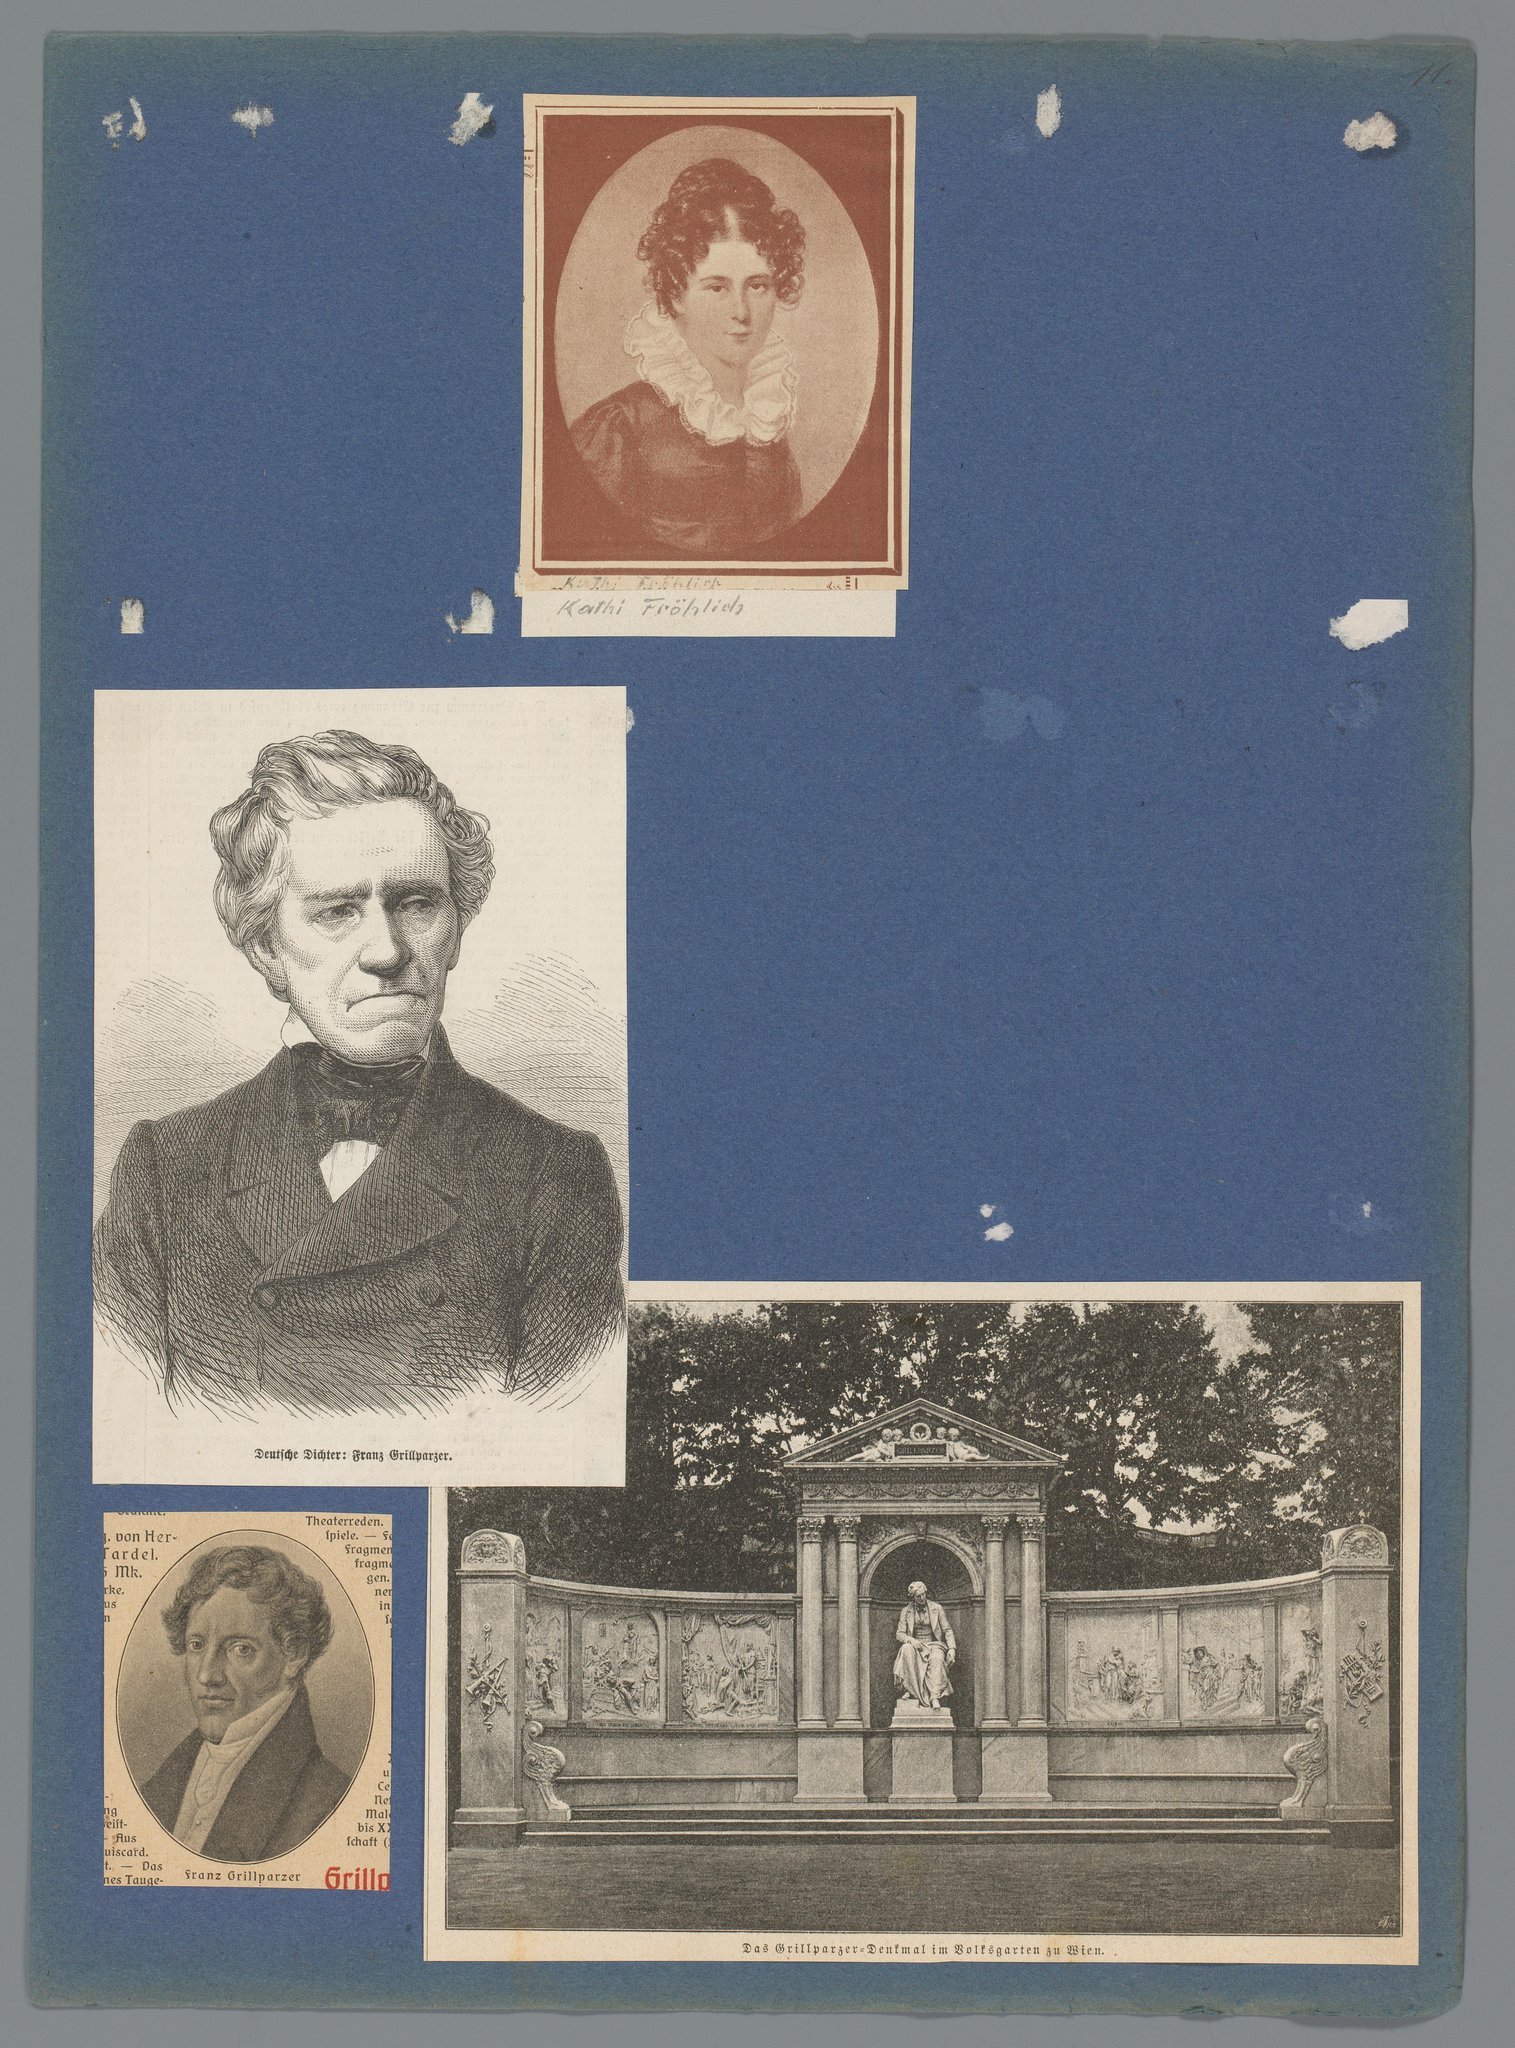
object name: print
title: Blad met één portret van Katharina Fröhlich, twee van Franz Grillparzer en een afbeelding van zijn grafmonument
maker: Anonymous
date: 1850-1900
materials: paper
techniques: letterpress printing, snipping, engraving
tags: vienna, historical persons - bb - woman, philantropist, historical persons, portrait of a writer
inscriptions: number: ‘11.’, signature: ‘AG pin’